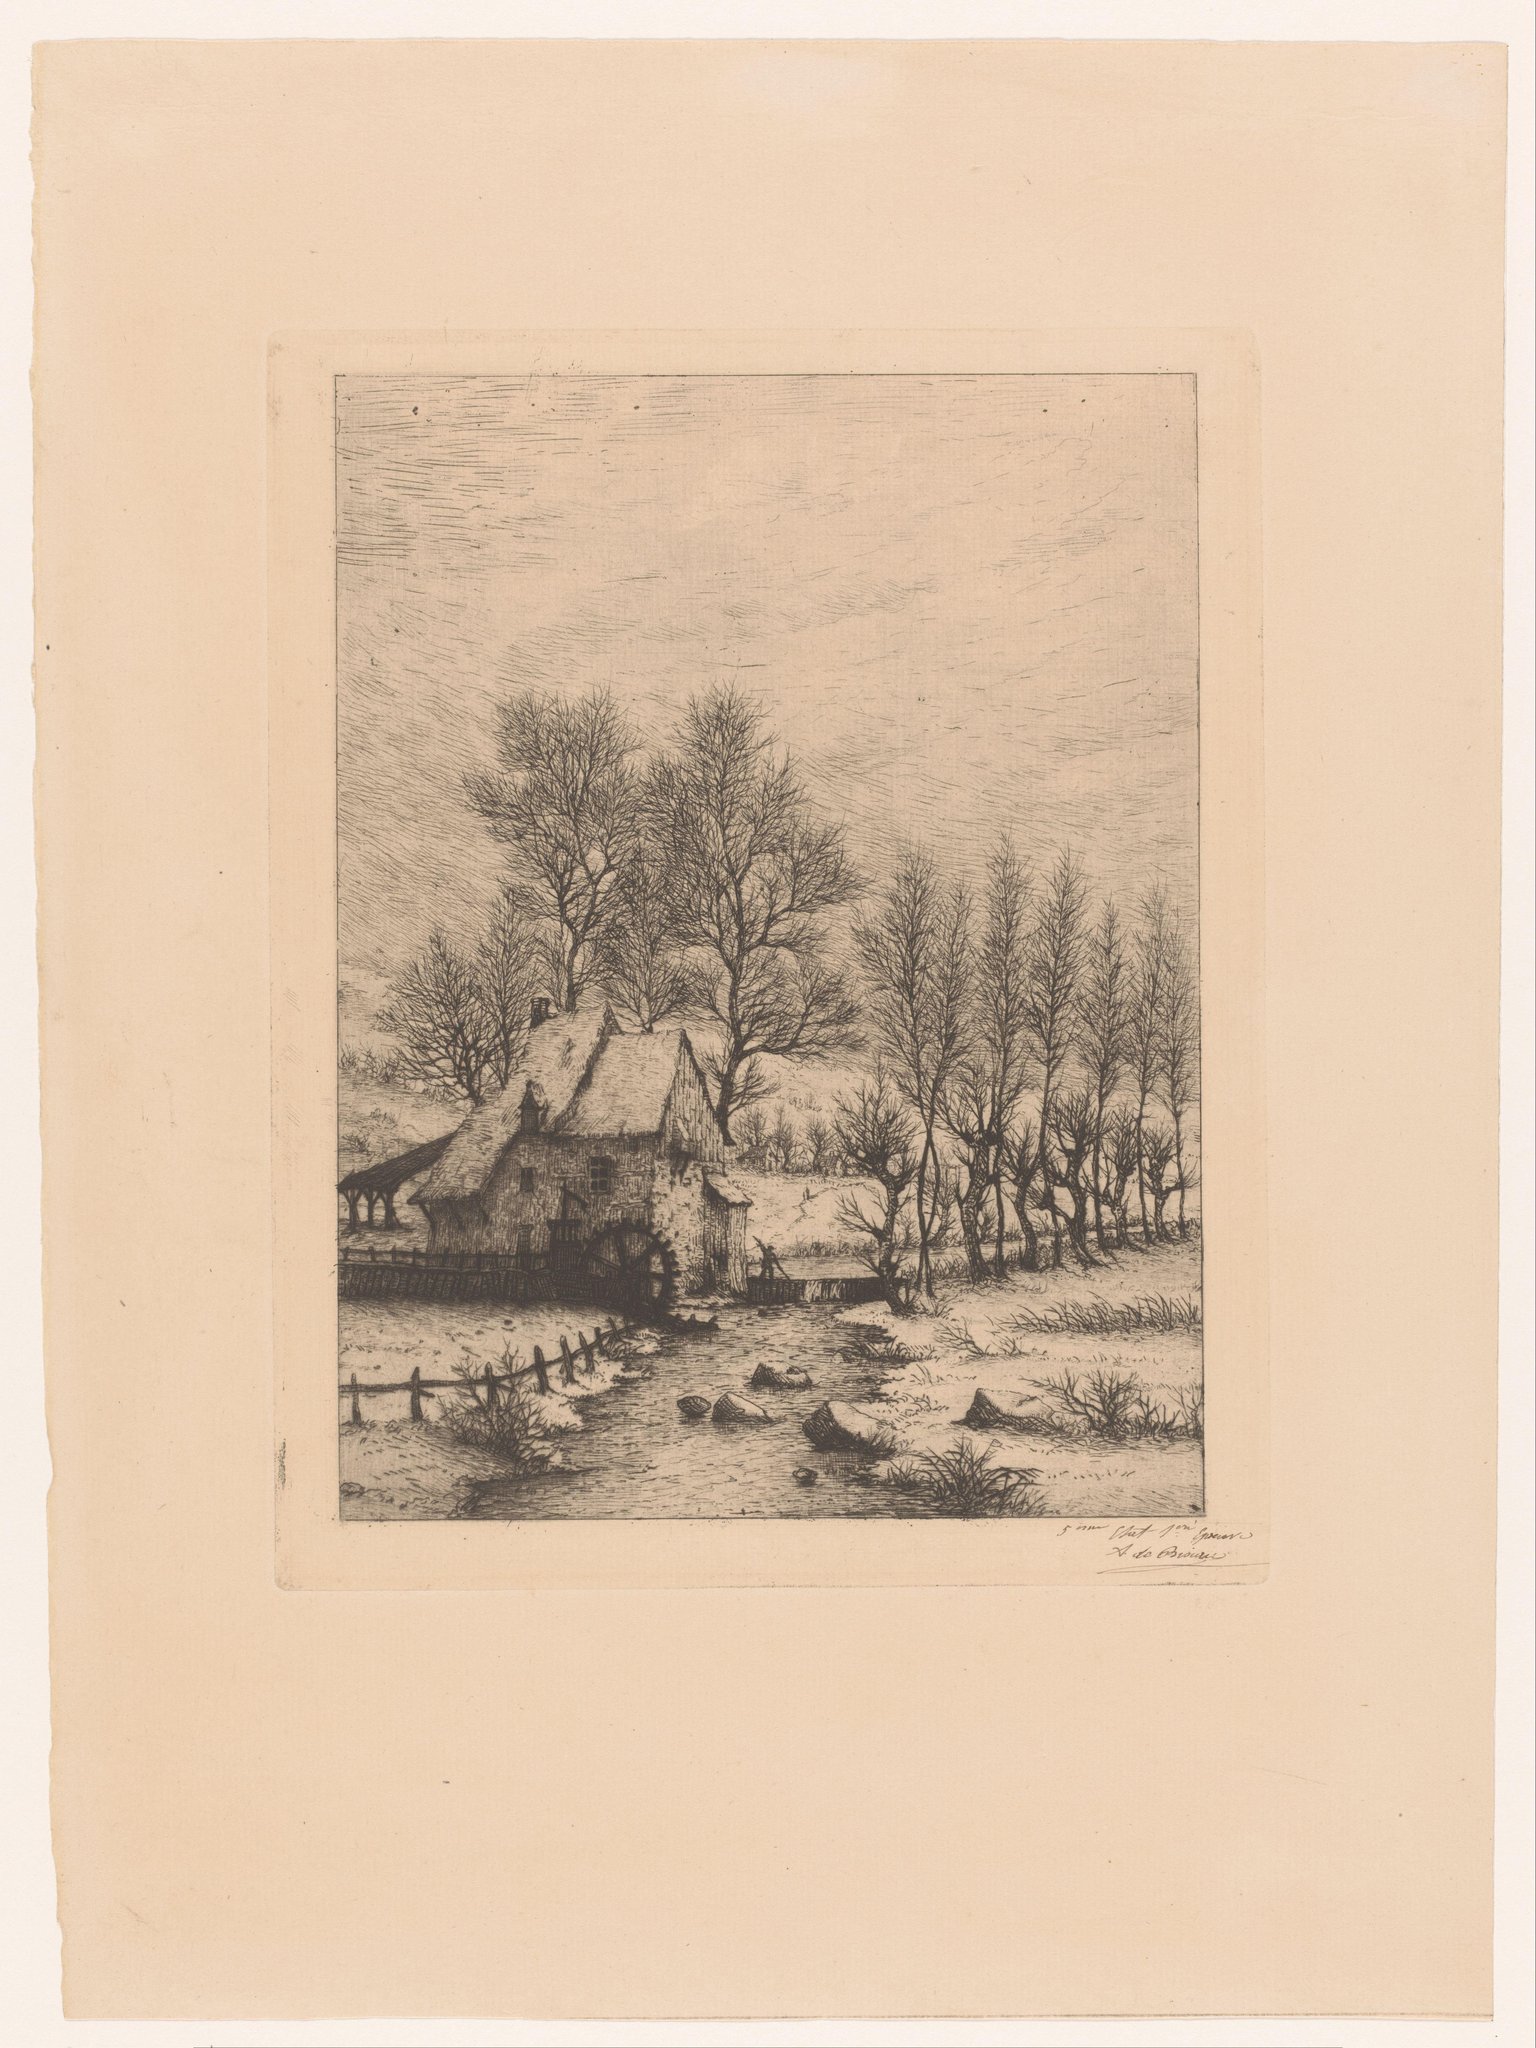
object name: print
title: Winterlandschap met watermolen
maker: aristide de biseau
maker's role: print maker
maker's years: 1844-1883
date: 1854-1883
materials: paper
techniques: drypoint, etching, intaglio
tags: watermill in landscape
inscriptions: annotation: ‘5eme Etat 1ere Epreuve’